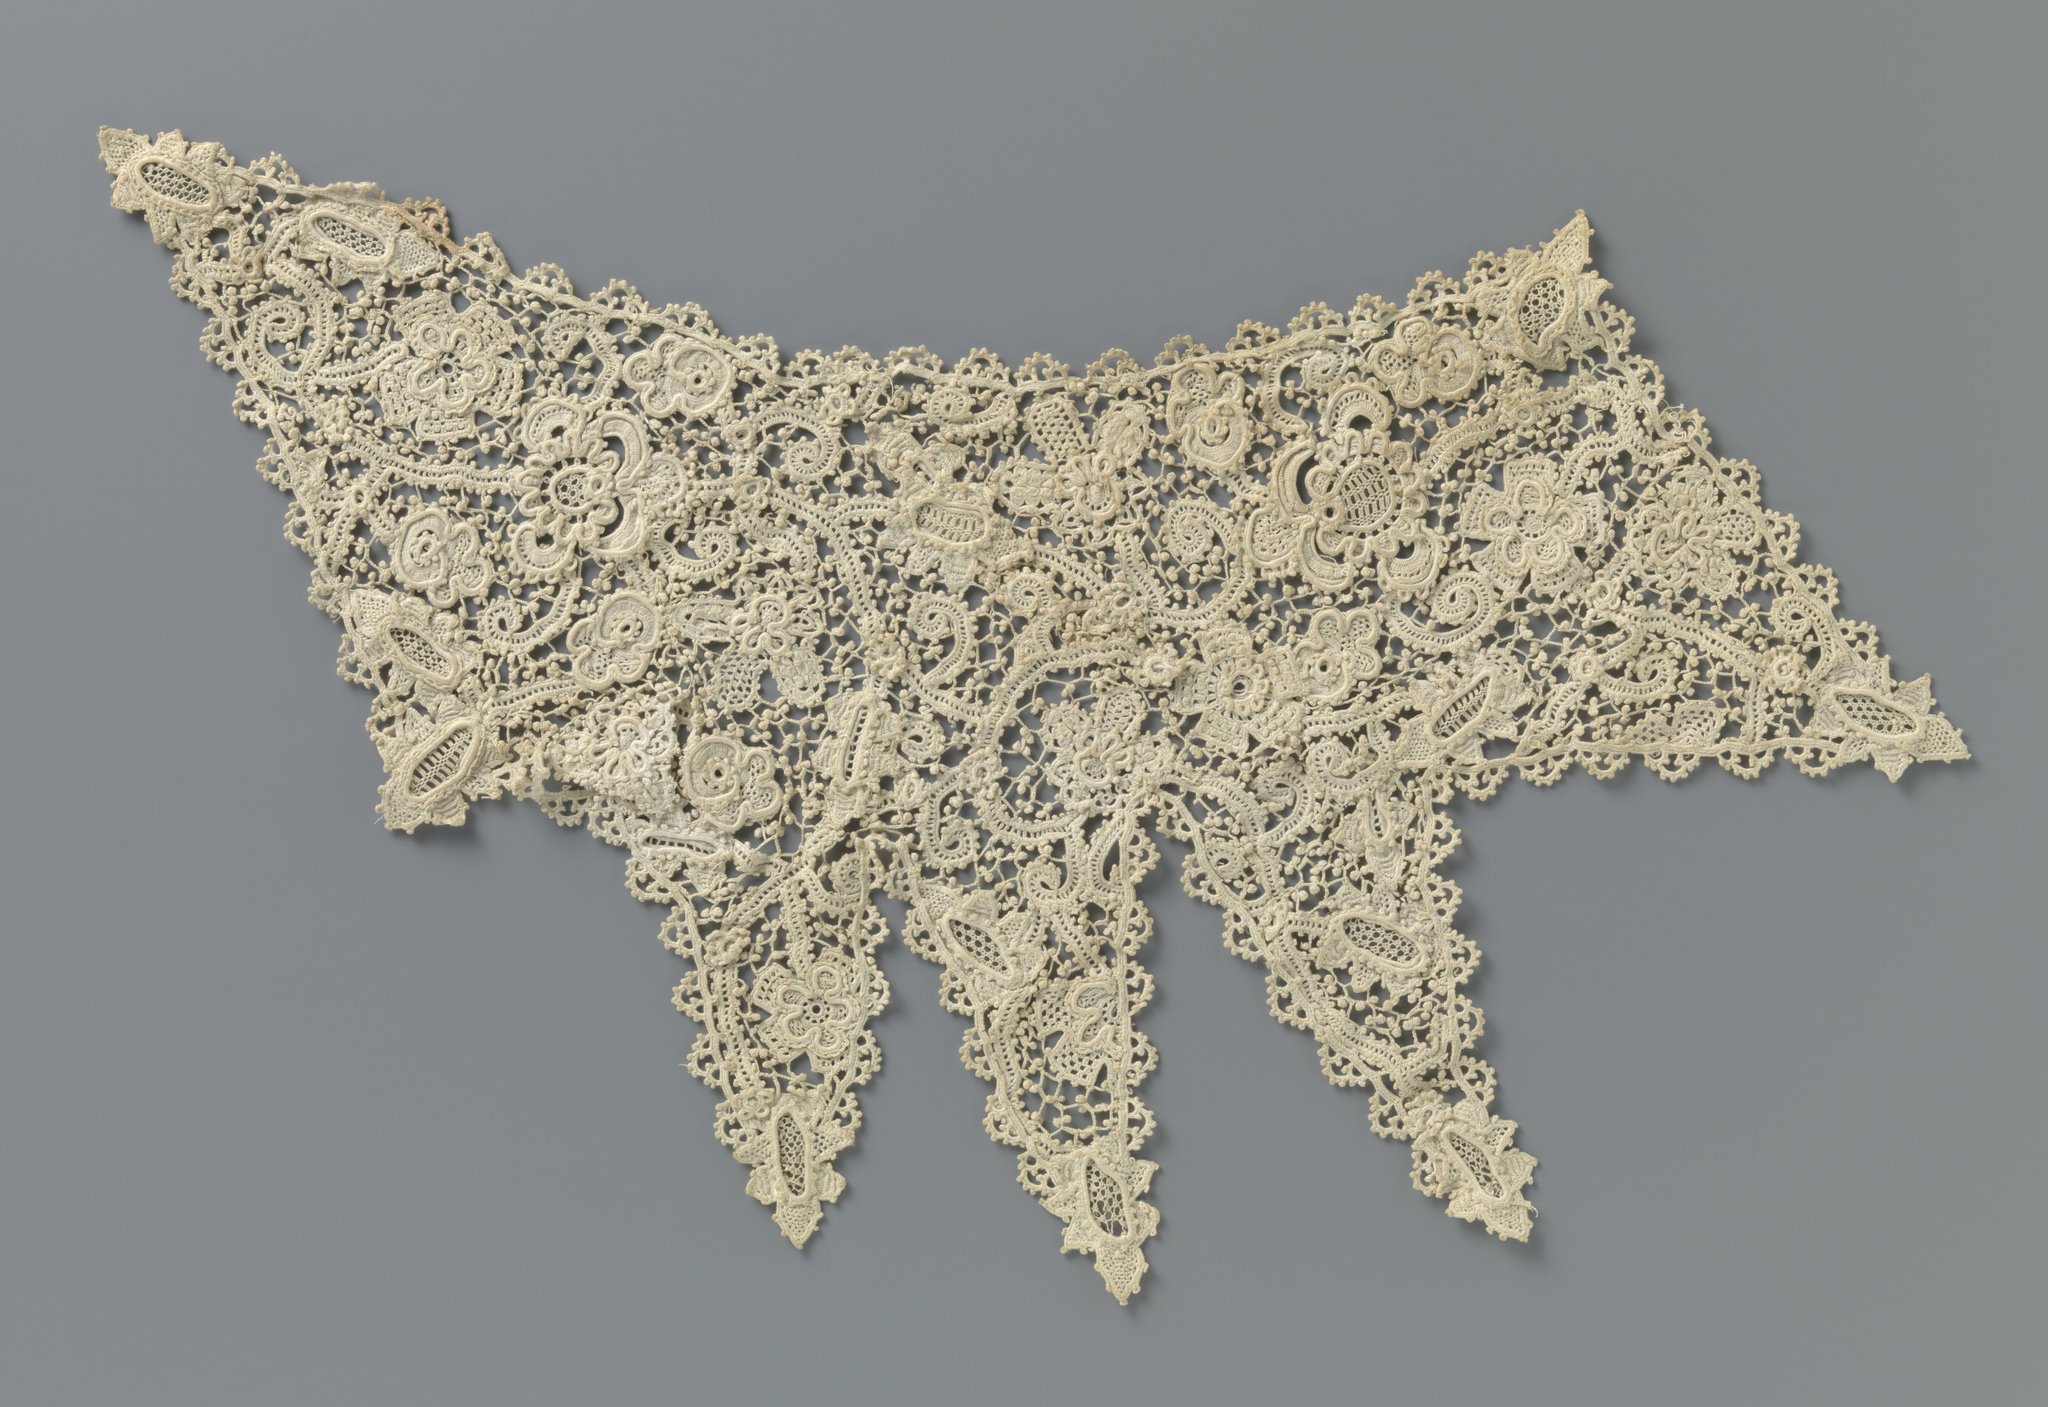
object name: collar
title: Deel van een kraag van gehaakte kant imitatie grove Venetiaanse naaldkant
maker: Anonymous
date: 1890-1909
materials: cotton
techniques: crocheted lace, irish crochet lace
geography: ireland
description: Het is een aanname dat deze Ierse gehaakte kant ook daadwerkelijk in Ierland is gemaakt. Ierse gehaakte kant kent zijn oorsprong rond 1760 en kwam vanaf 1840 in ontwikkeling. Aangezien volgens Martine Bruggeman (Kant in Europa) de Ierse haakindustrie aan het eind van de 19e eeuw gereorganiseerd werd en in populariteit groeide, is het hier beschreven stuk gedateerd rond 1890, tot 1909 vanwege de datering in het eerste decennium van populariteit van Ierse gehaakte kant volgens het Kantlexicon (Johan Coene).